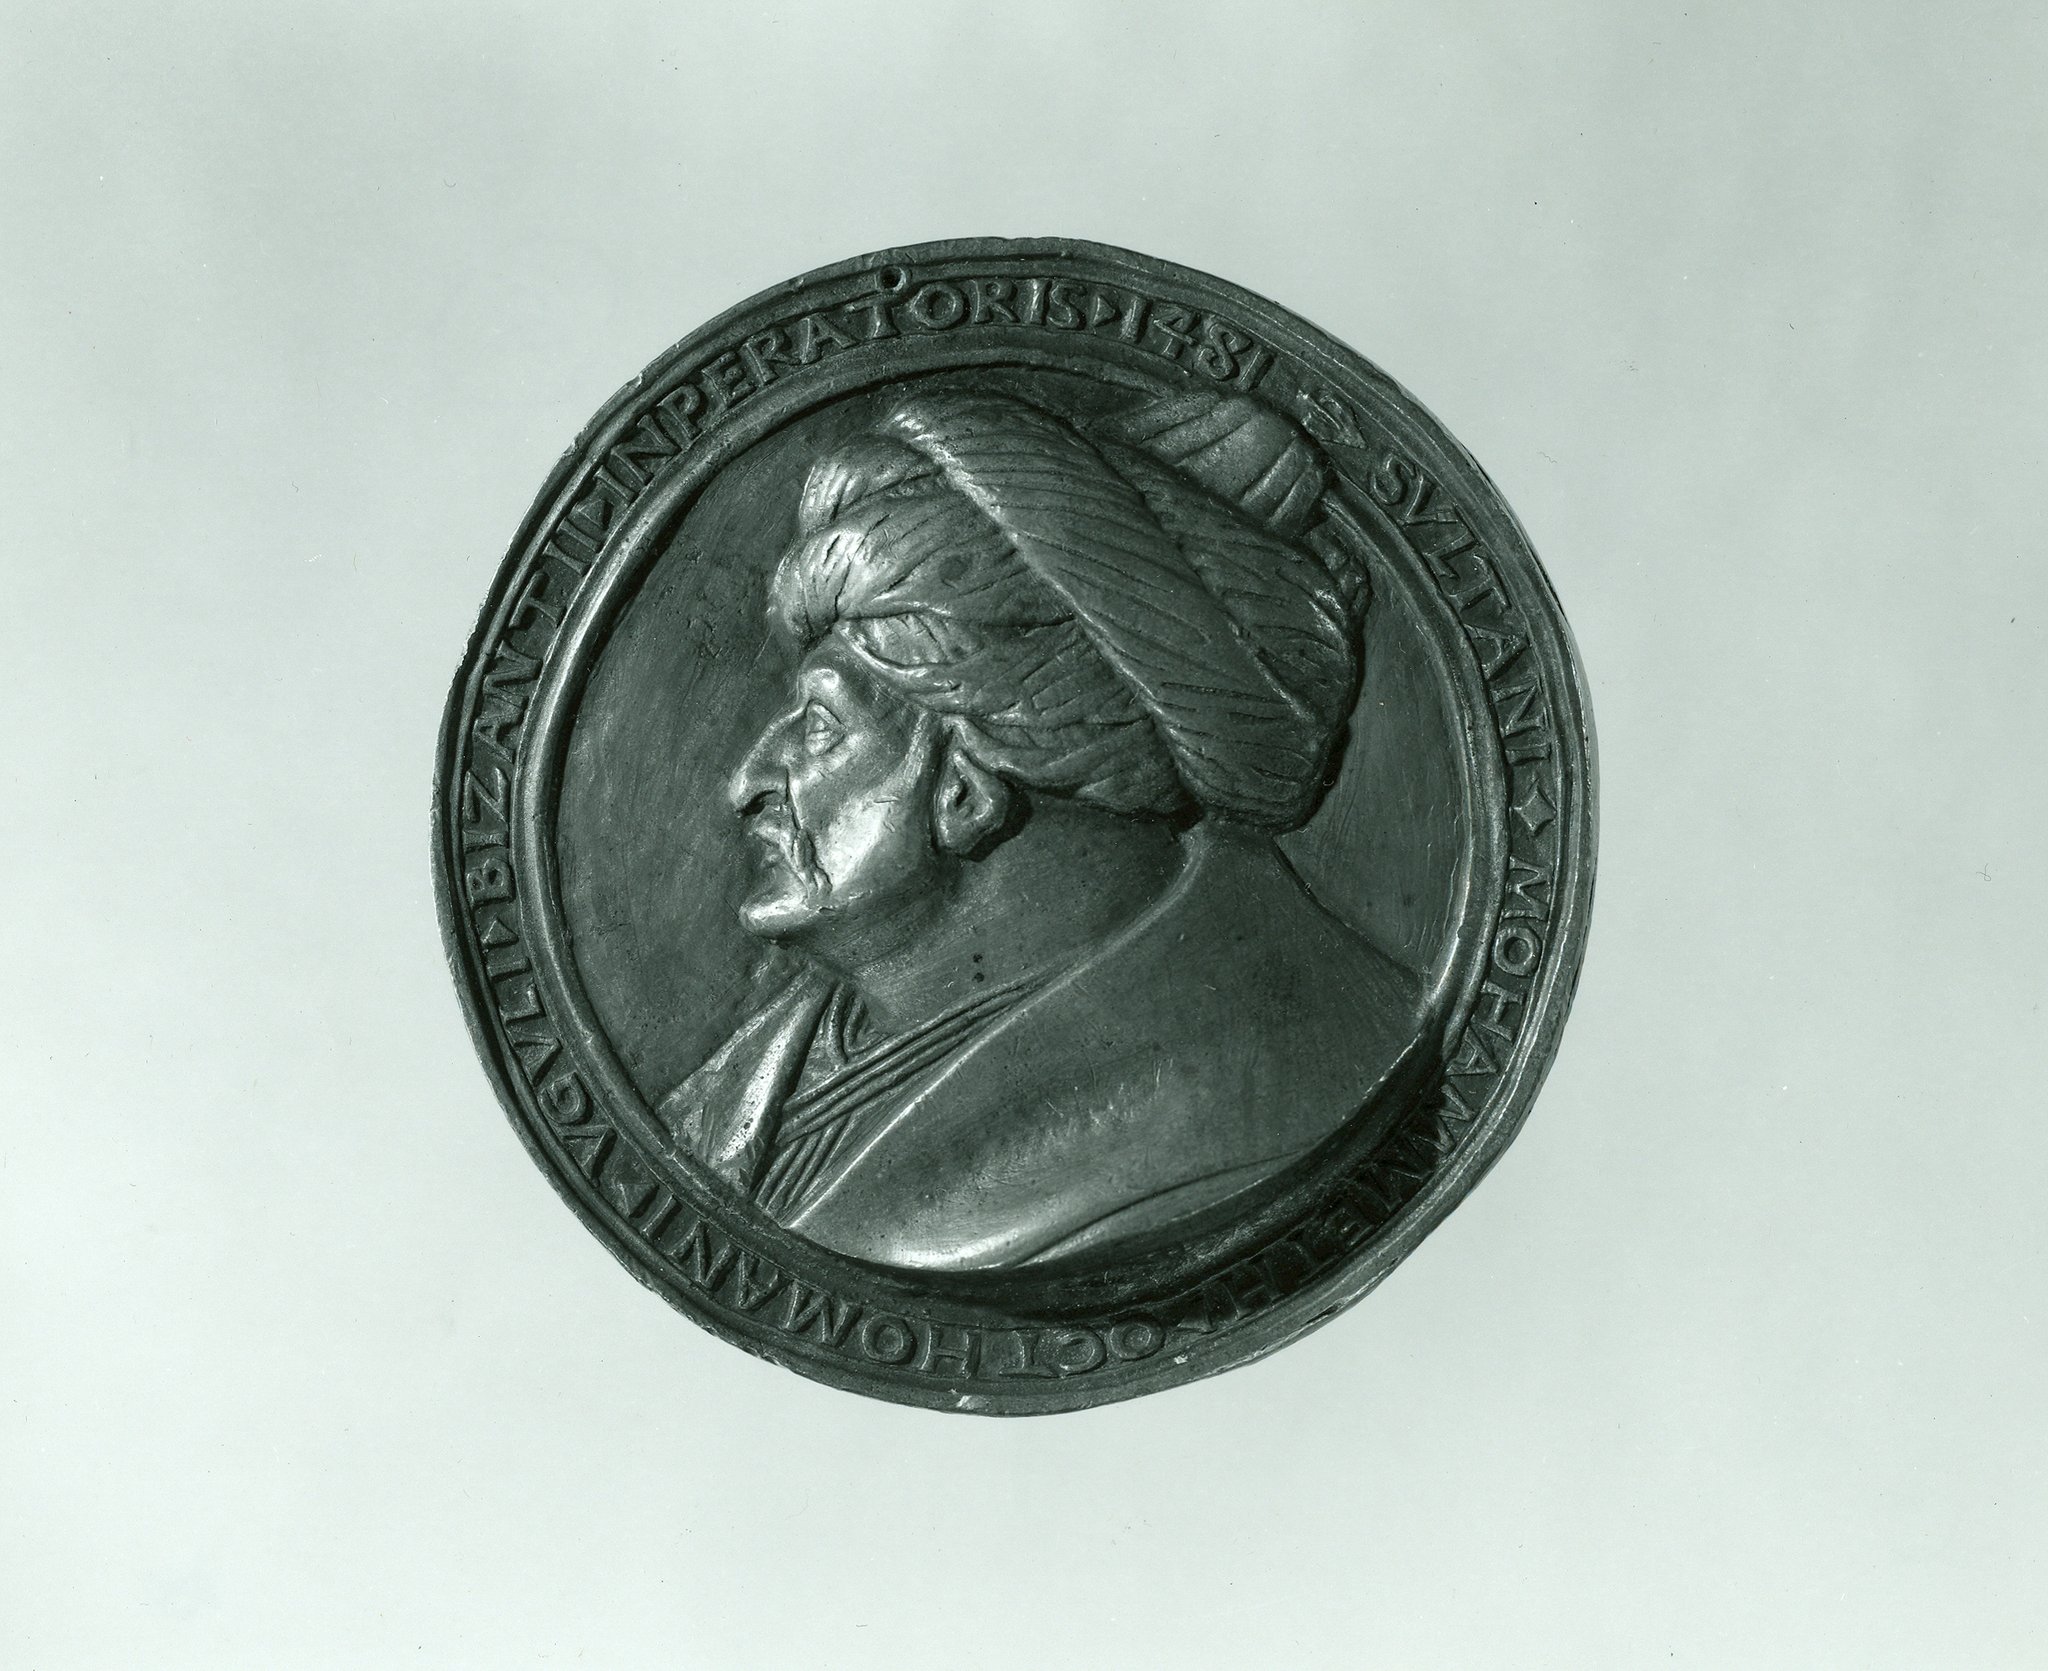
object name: medal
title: Medal: Sultan Mehmed II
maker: costanzo da ferrara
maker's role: artist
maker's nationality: italian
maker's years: 1440-1524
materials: bronze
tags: men,portraits,profiles